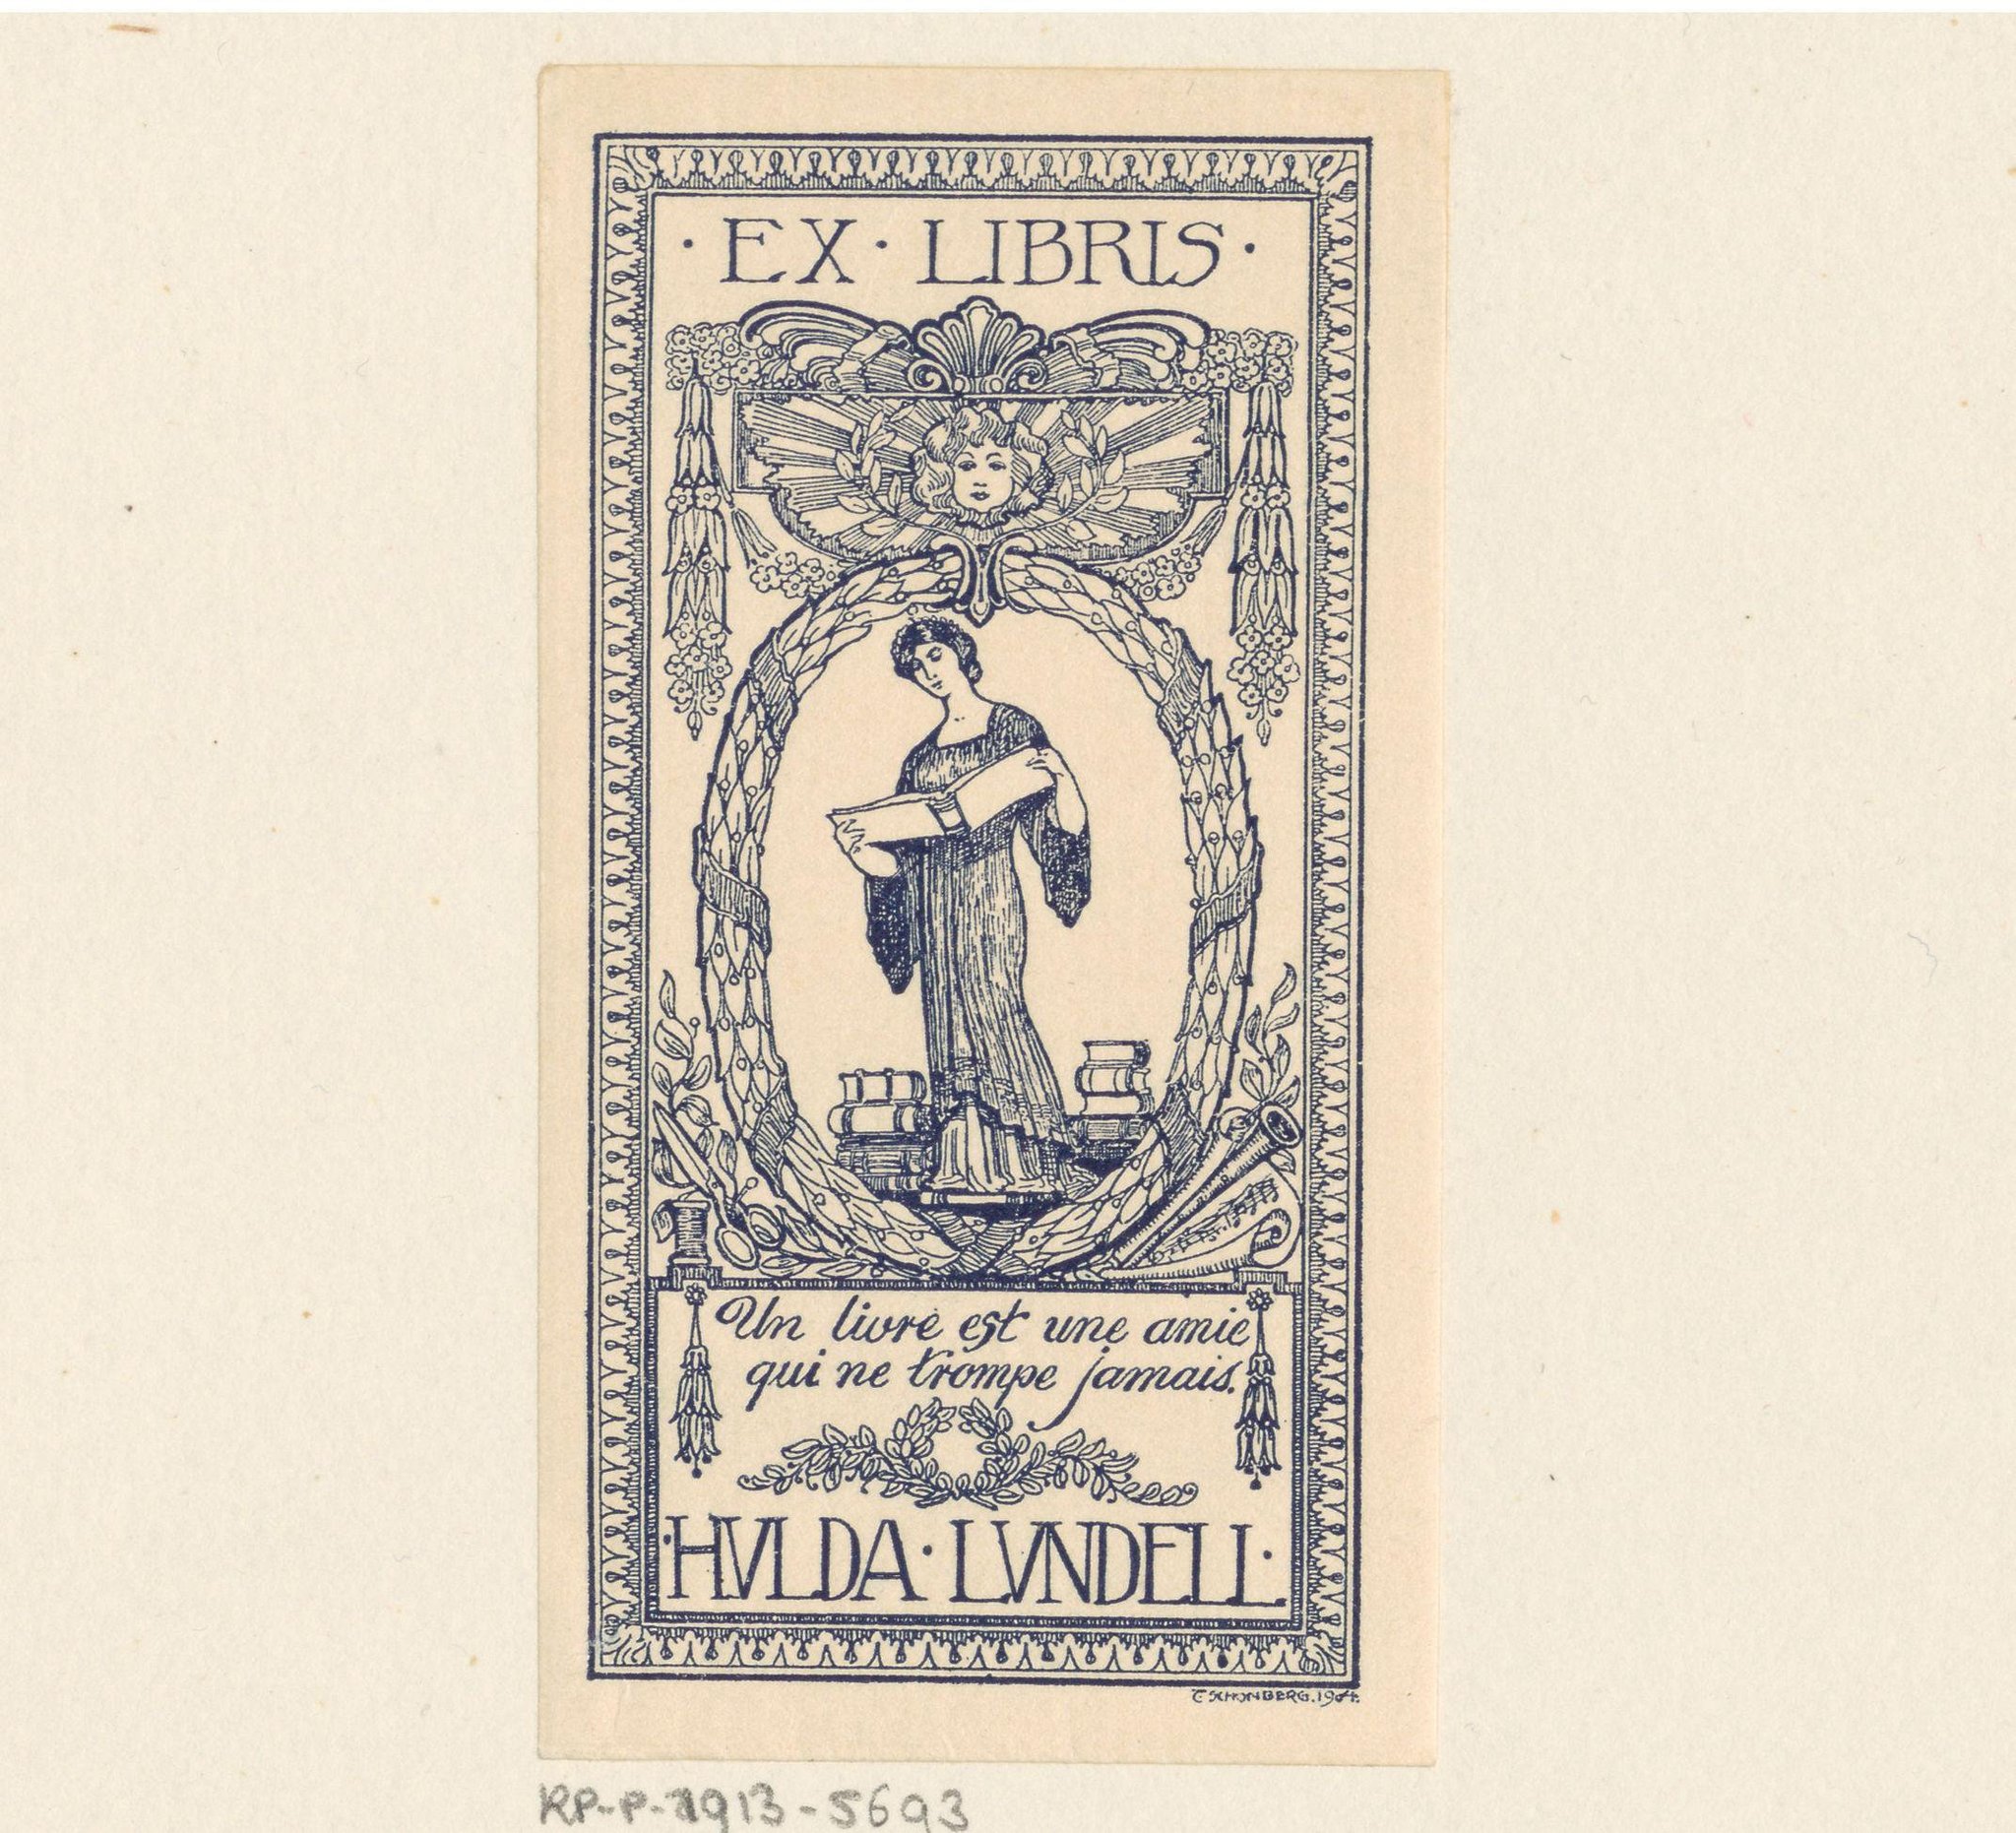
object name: bookplate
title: Un livre est une amie qui ne trompe jamais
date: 1904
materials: paper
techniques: printing block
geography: sweden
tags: cherubs, i.e. children's heads with wings, reading, garland, wreath, book, standing figure - aa - female human figure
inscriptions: collector's mark: Lugt 2233, collector's mark: Lugt 2760